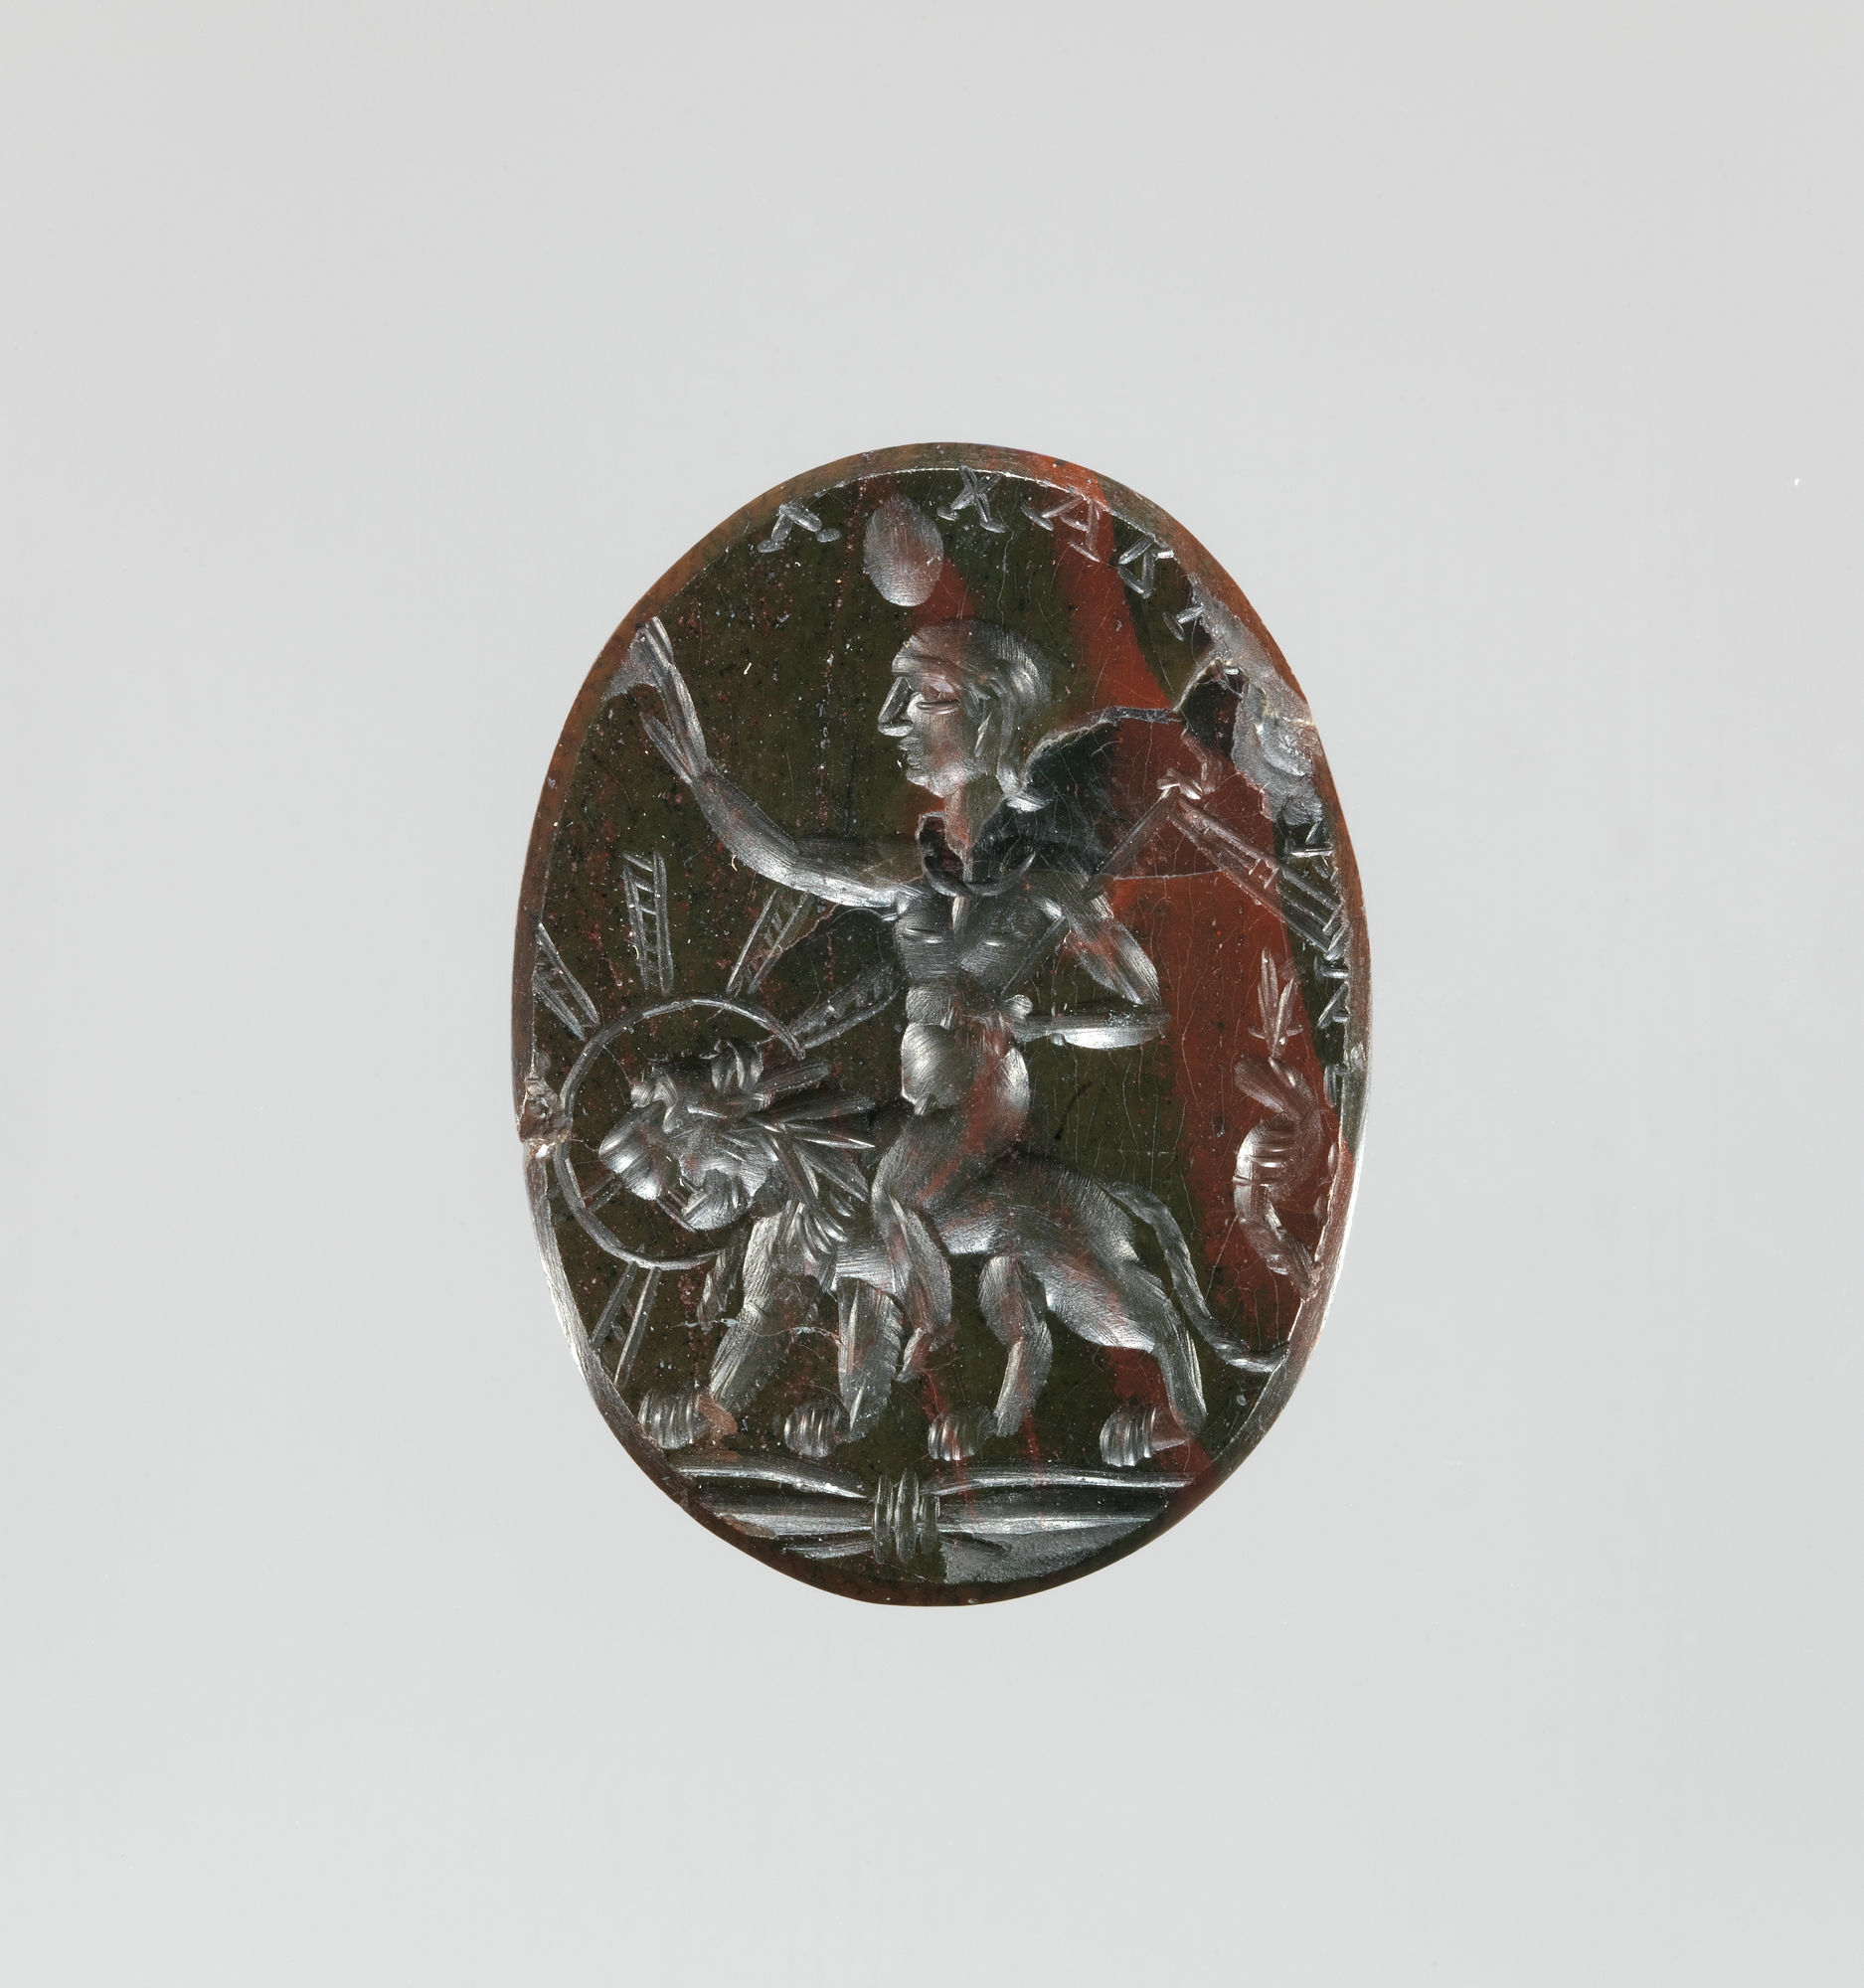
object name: intaglio, magical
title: Jasper intaglio: Harpocrates riding a lion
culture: roman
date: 101-300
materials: jasper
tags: lions,harpokrates